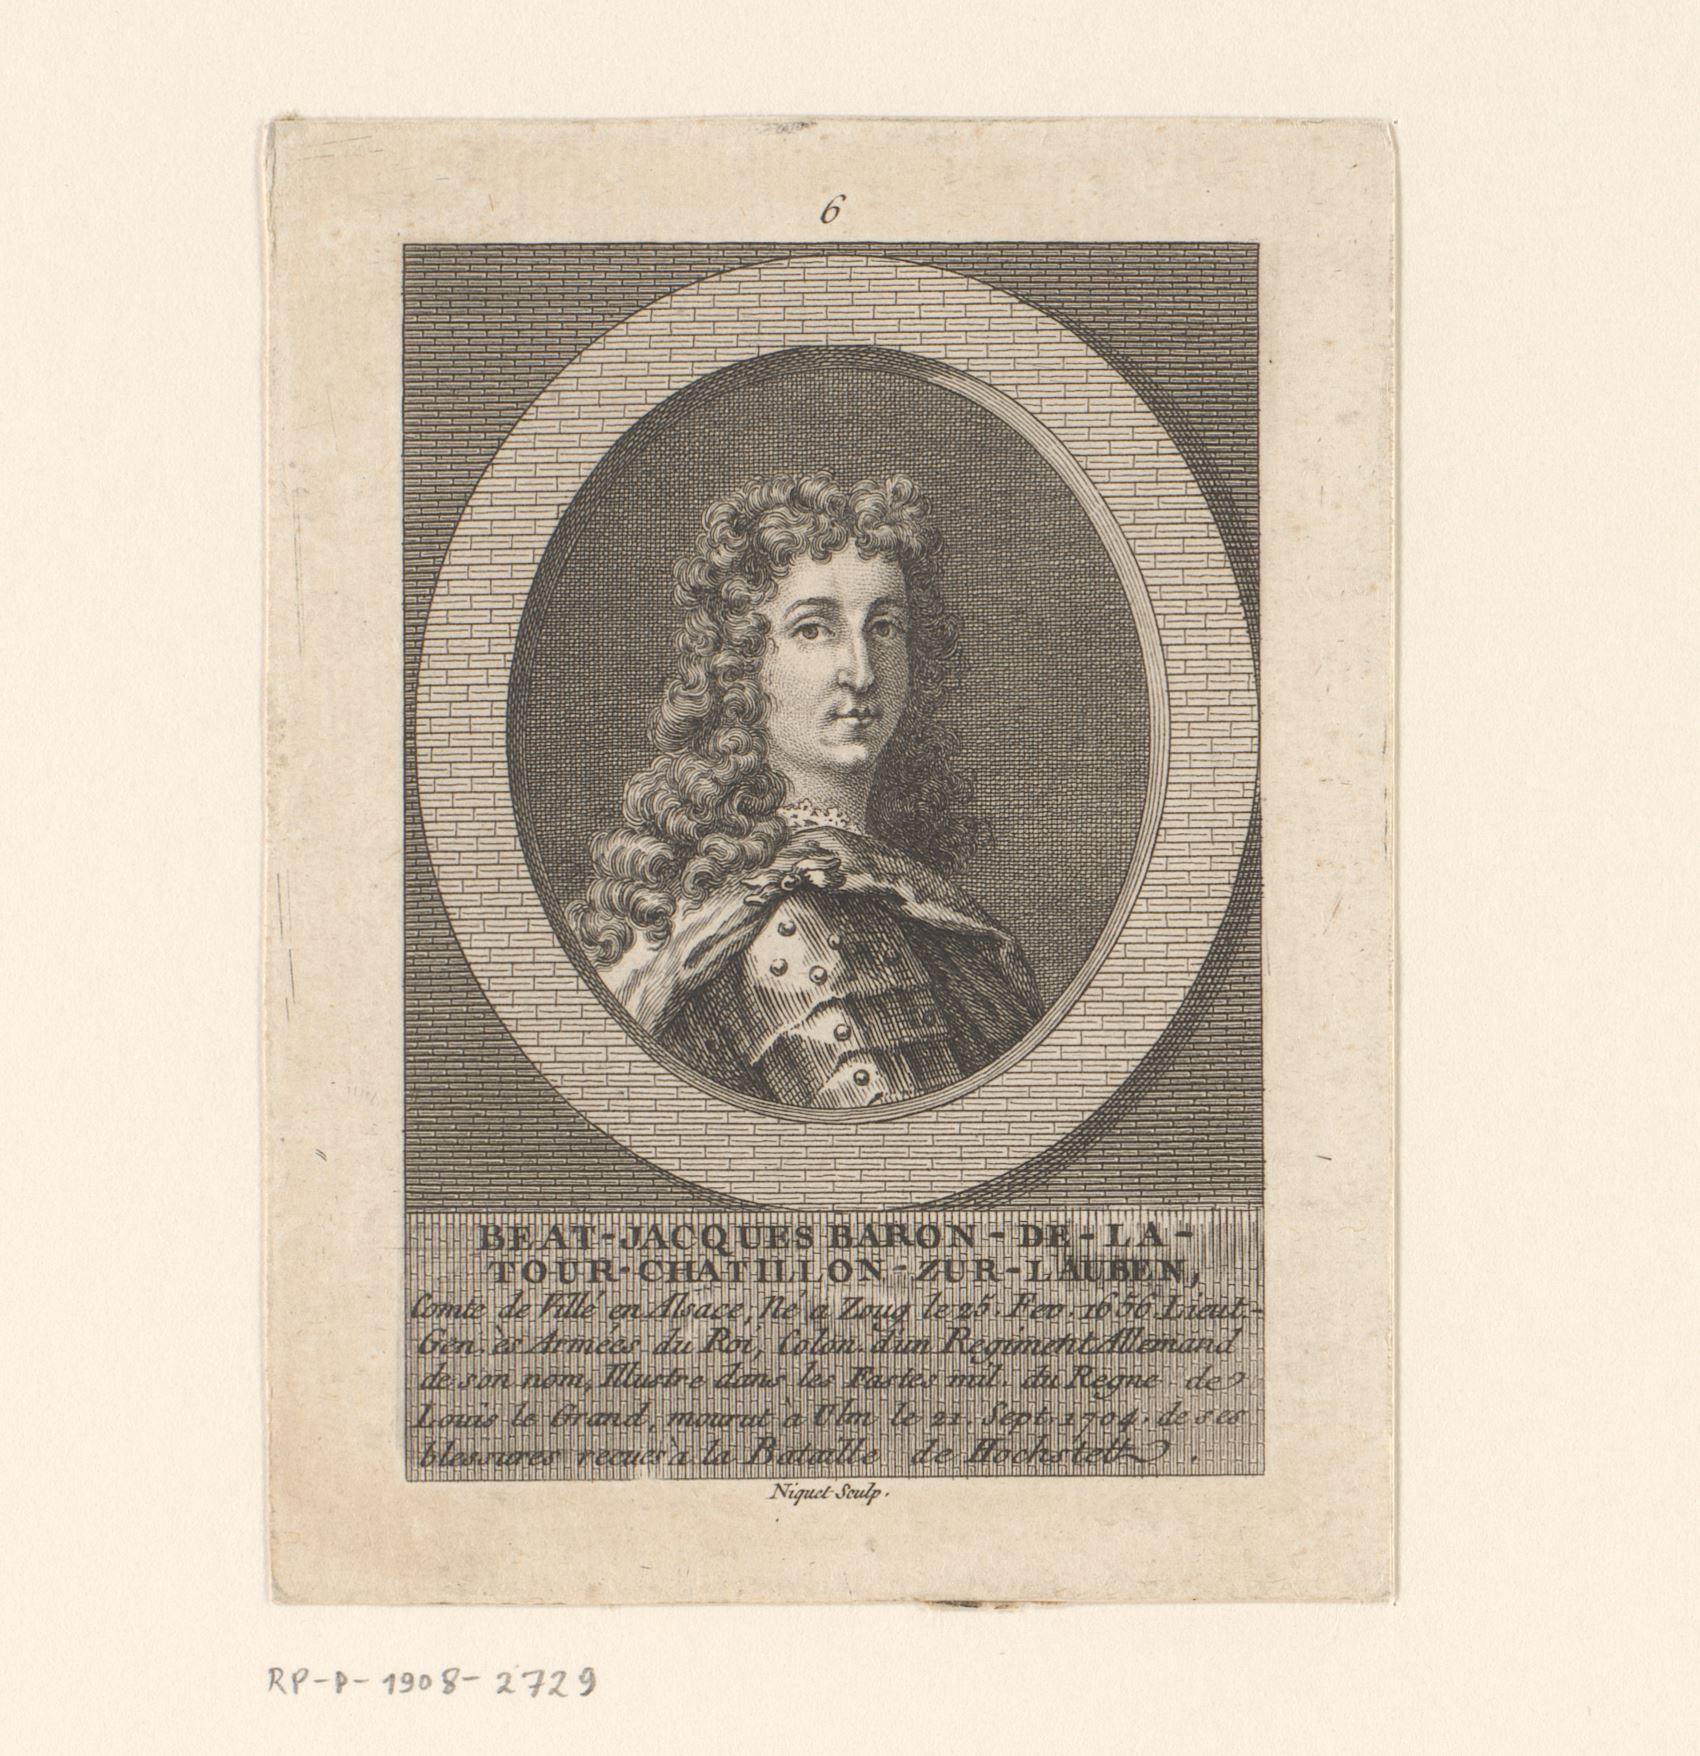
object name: print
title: Portret van Béat Jacques II de Zurlauben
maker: claude niquet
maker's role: print maker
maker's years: 1760-1831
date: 1770-1831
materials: paper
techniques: etching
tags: ranks in the army, historical persons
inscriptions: collector's mark: Lugt 2228